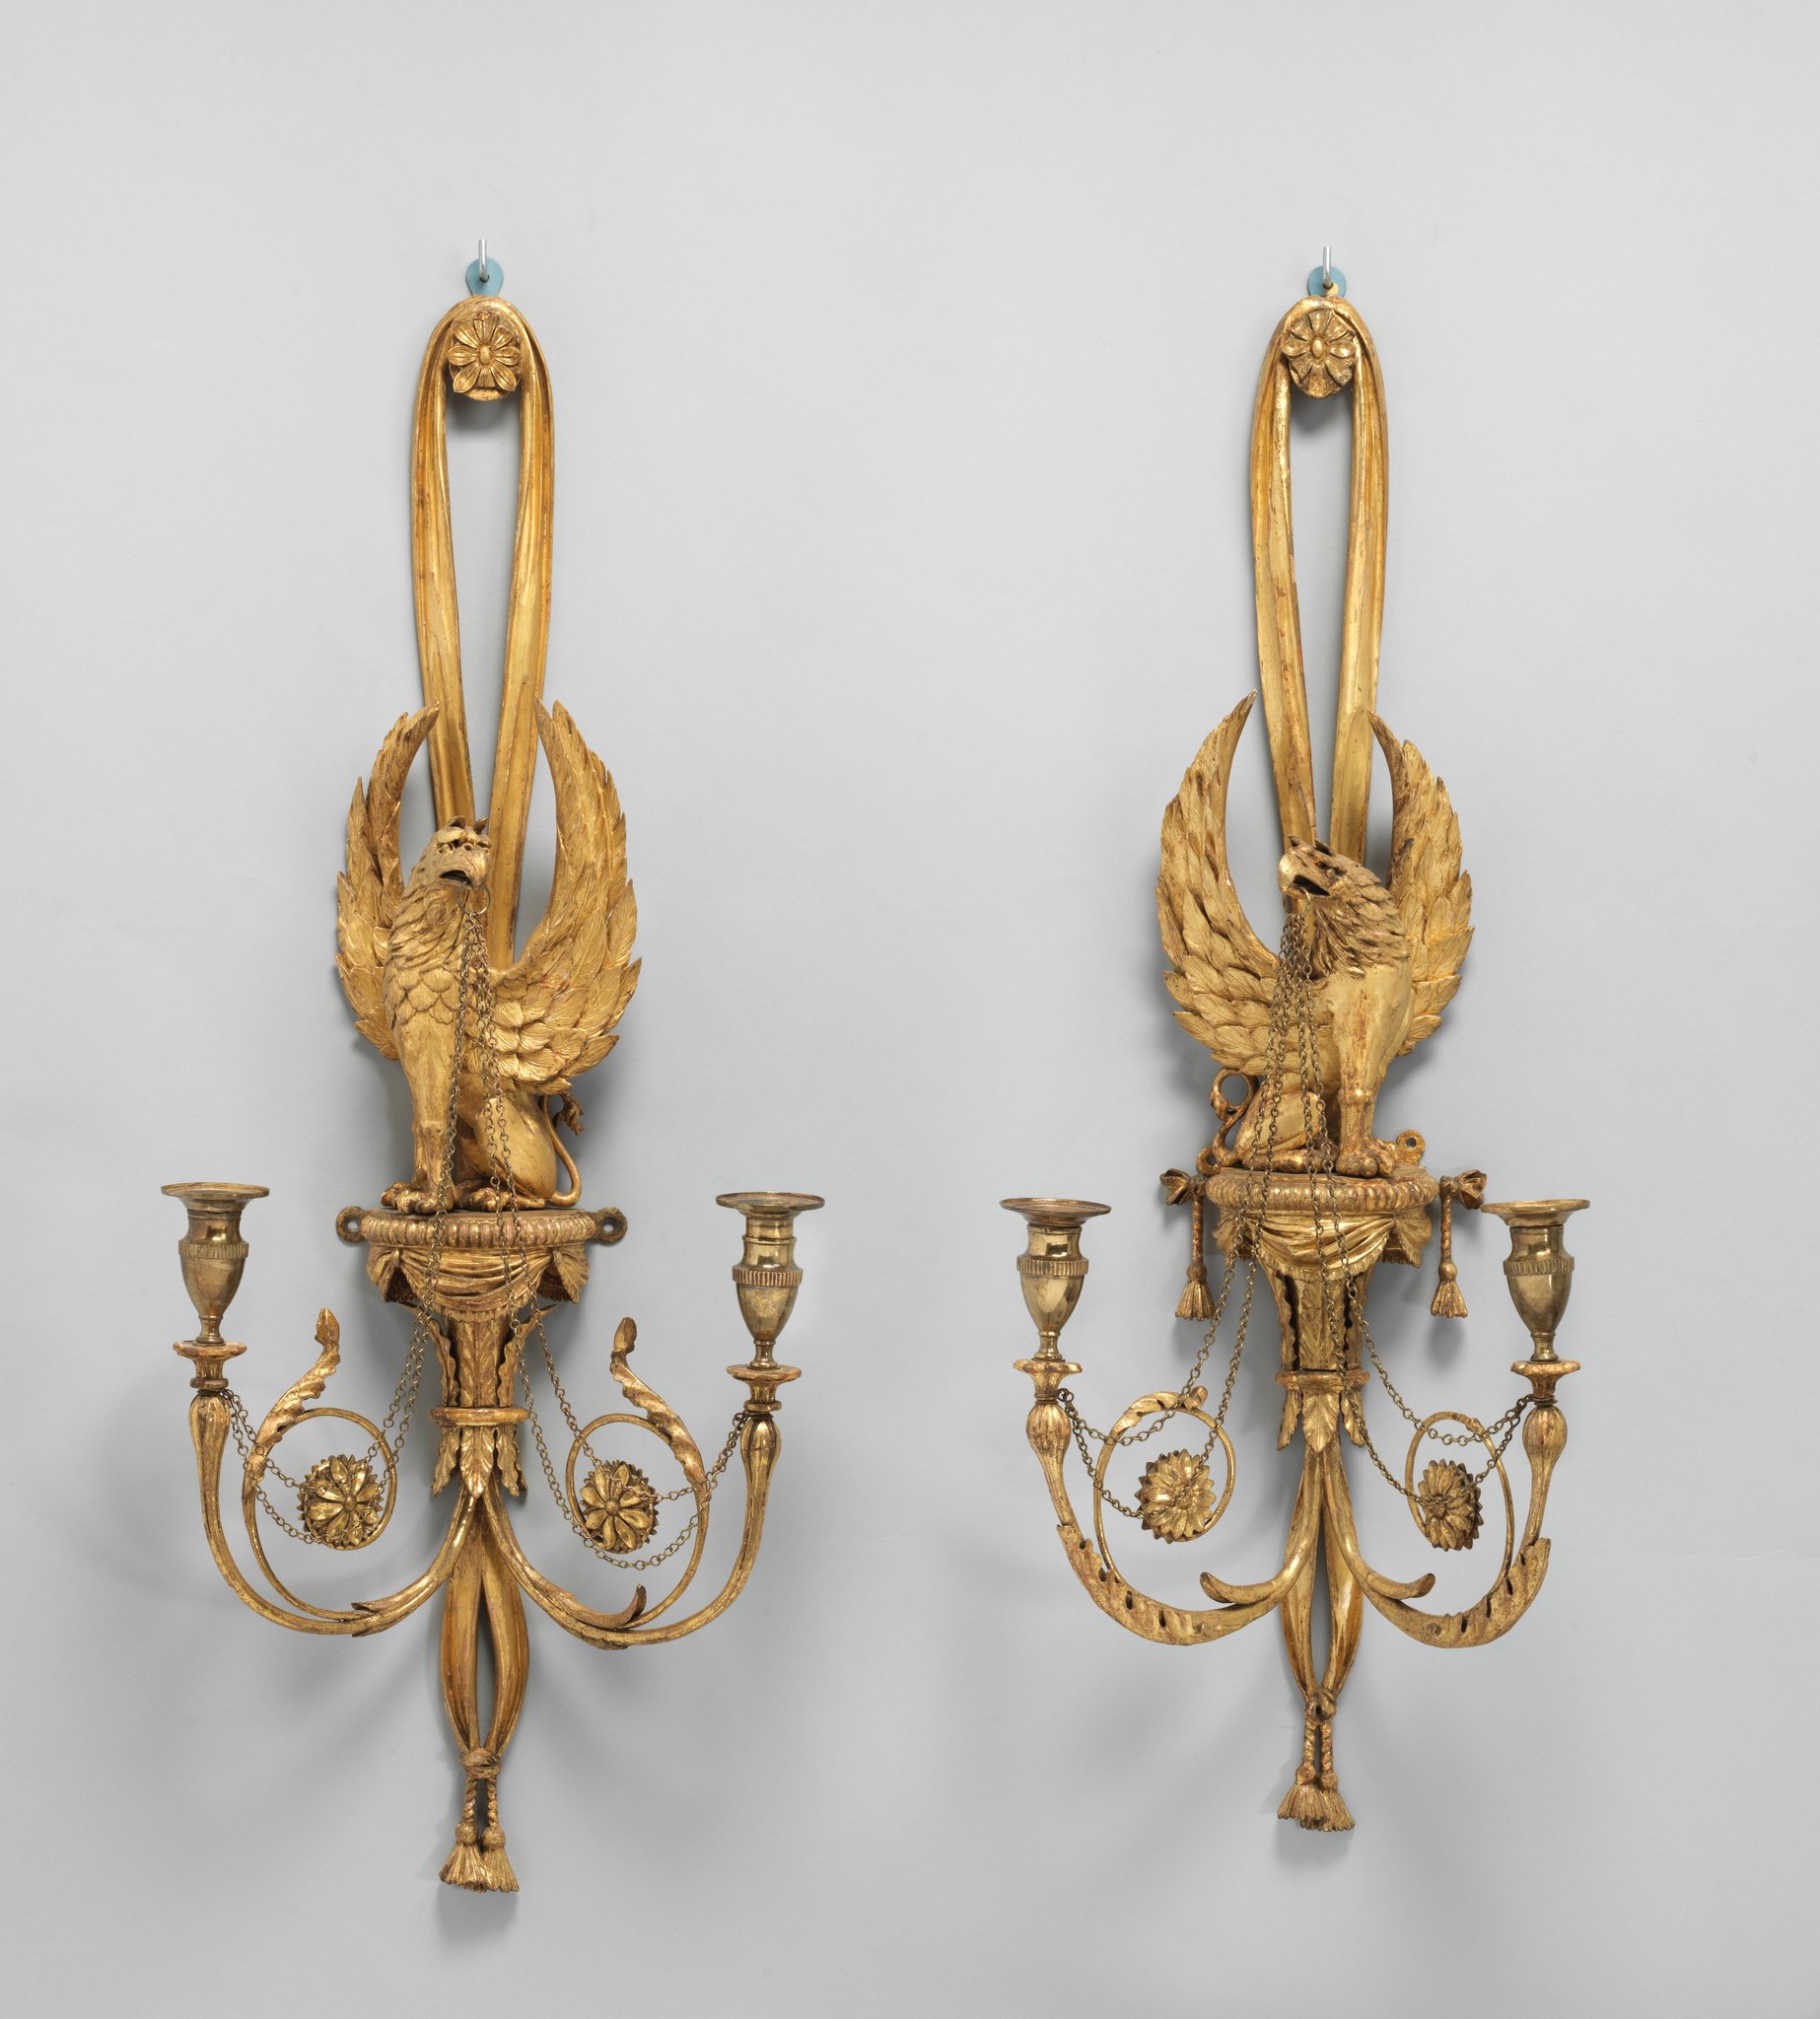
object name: sconce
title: Sconce (one of a pair)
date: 1790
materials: gesso, gilt brass, wood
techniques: gilding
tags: griffins